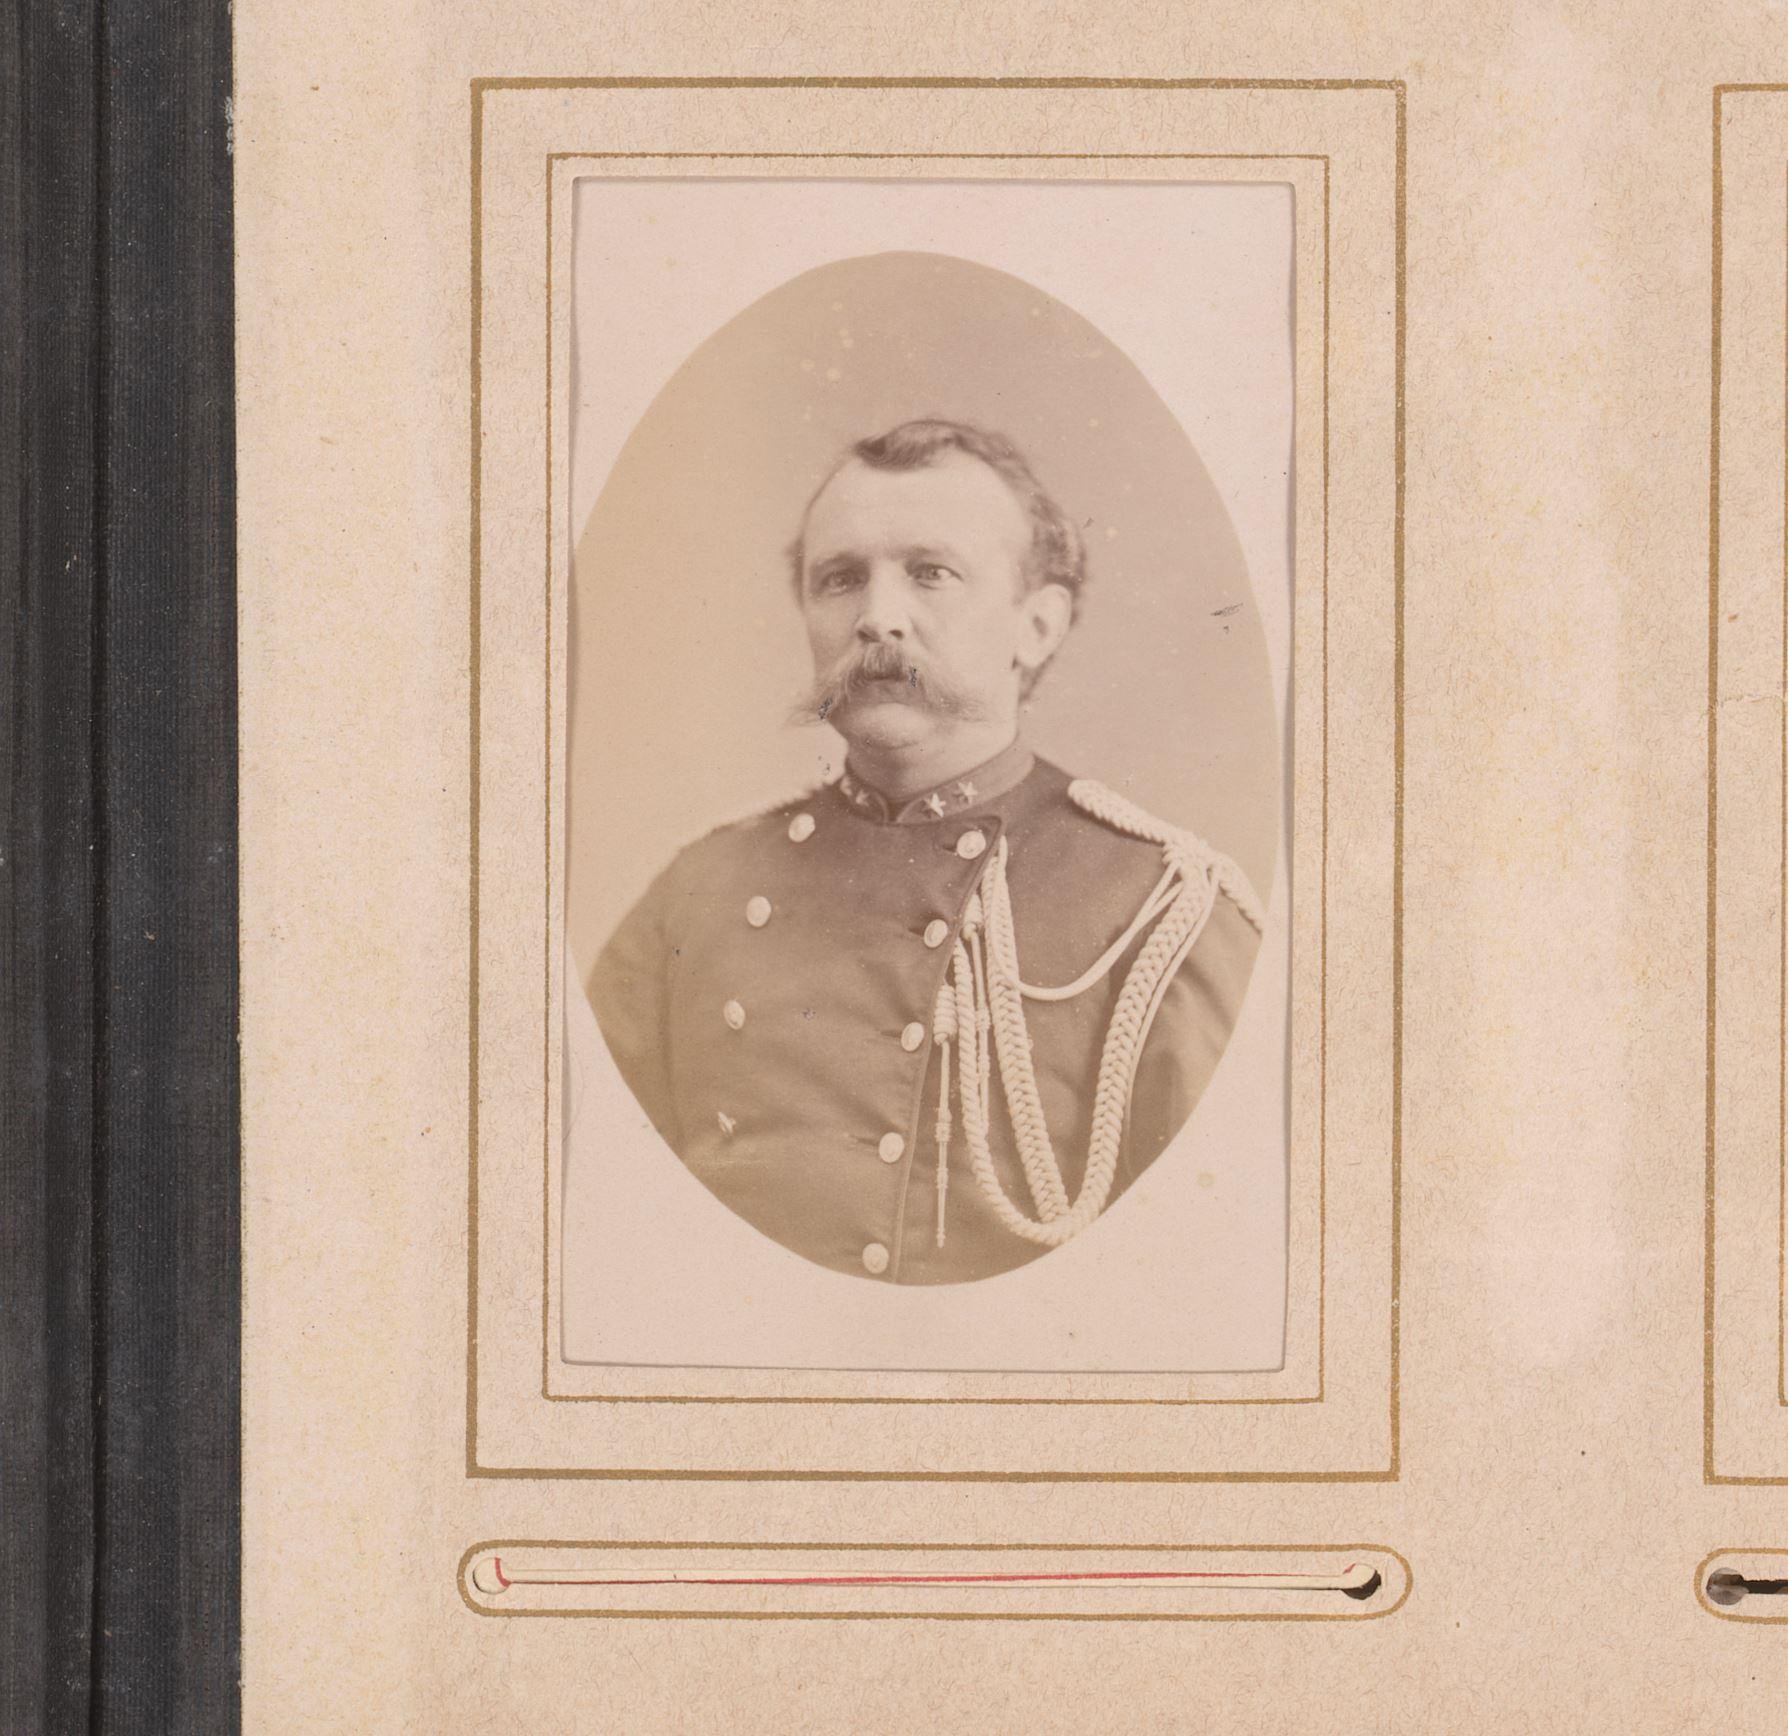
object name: carte de visite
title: Portret van een man in uniform met snor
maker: carl wilhelm bauer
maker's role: fotograaf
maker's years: 1844-1911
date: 1873-1908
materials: cardboard, photographic support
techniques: albumen print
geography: middelburg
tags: moustache, historical persons, (military) uniforms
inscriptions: inscription: ‘C.W. Bauer/ Photographe/ Middelburg’